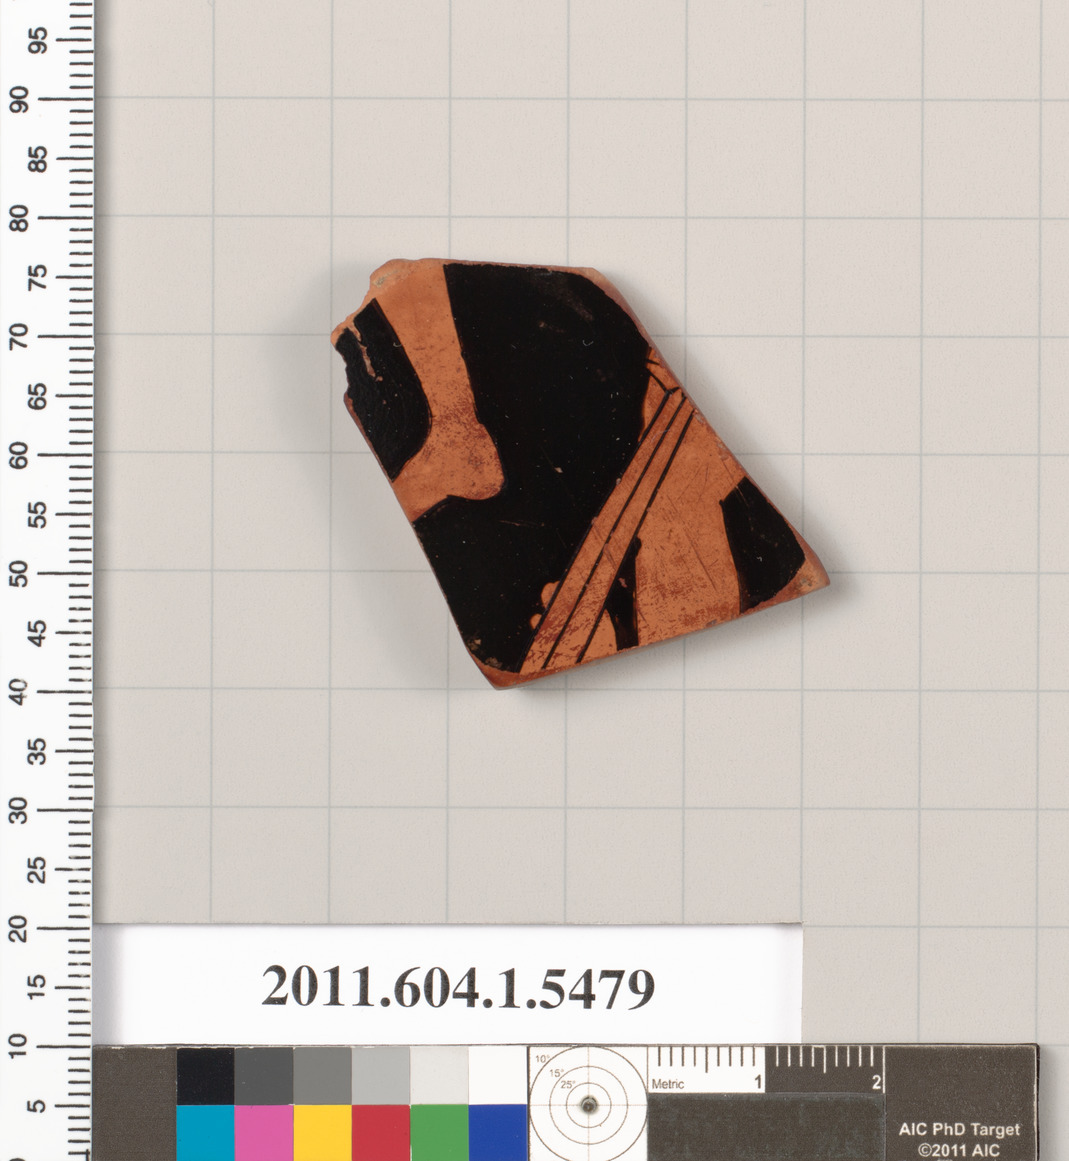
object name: kylix fragment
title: Terracotta fragment of a kylix (drinking cup)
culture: greek, attic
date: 500-480 BCE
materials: terracotta